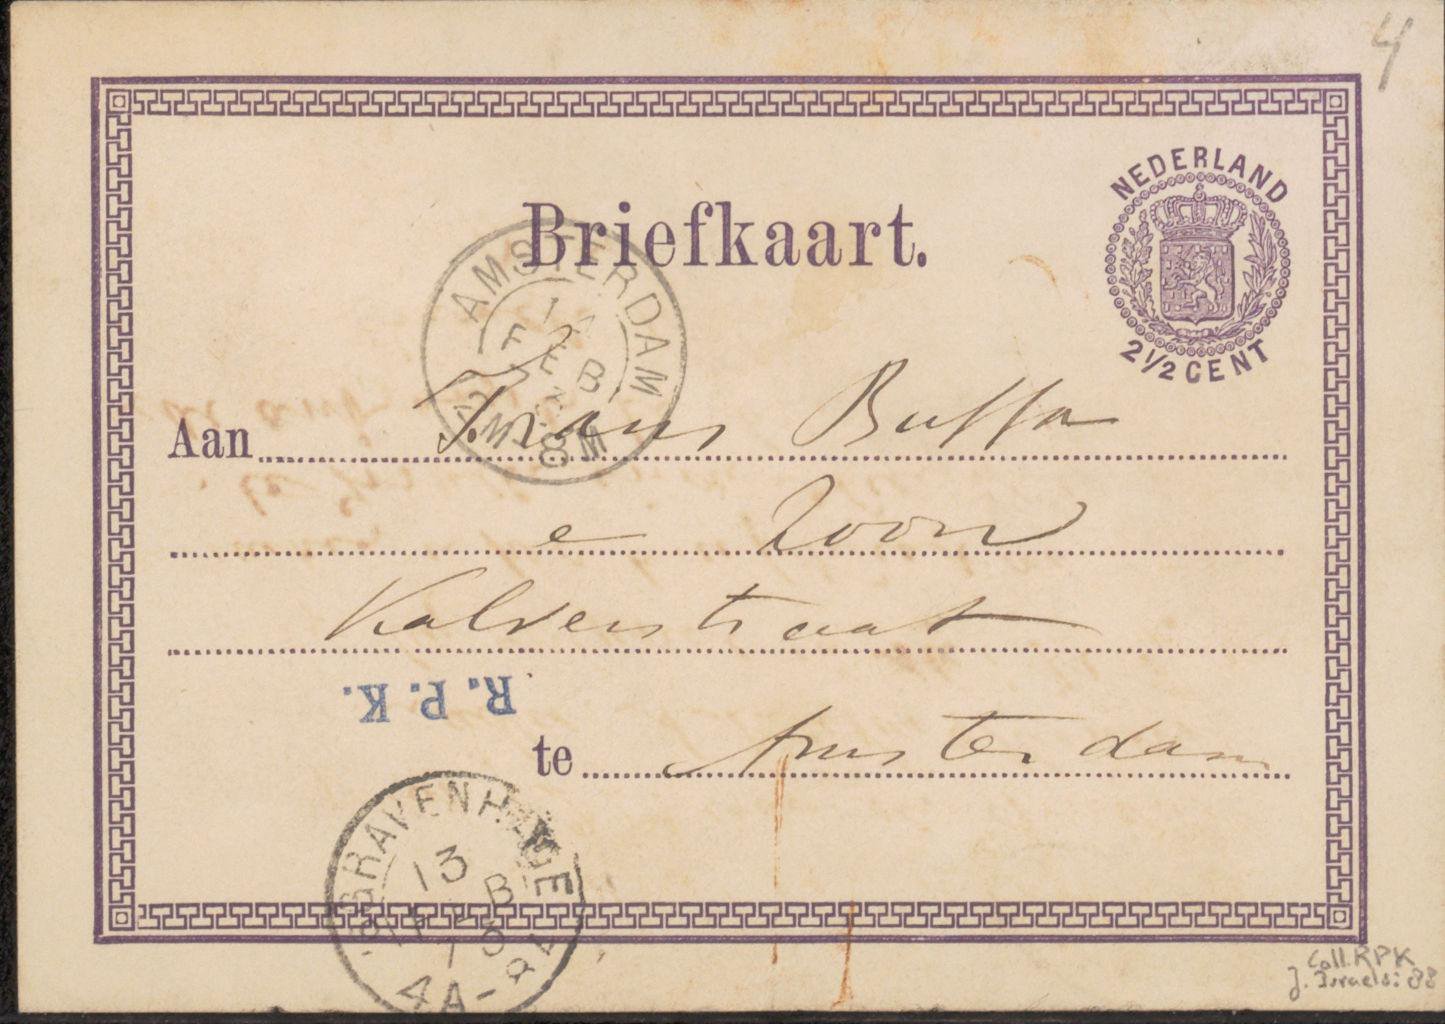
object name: postcard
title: Briefkaart aan Frans Buffa en Zonen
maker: jozef israëls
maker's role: draughtsman, painter, print maker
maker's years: 1824-1911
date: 1873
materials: cardboard, ink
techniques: pen, writing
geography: the hague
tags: print maker, philip gilbert hamerton, publisher, the graphic arts, money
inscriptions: collector's mark: Lugt 2233